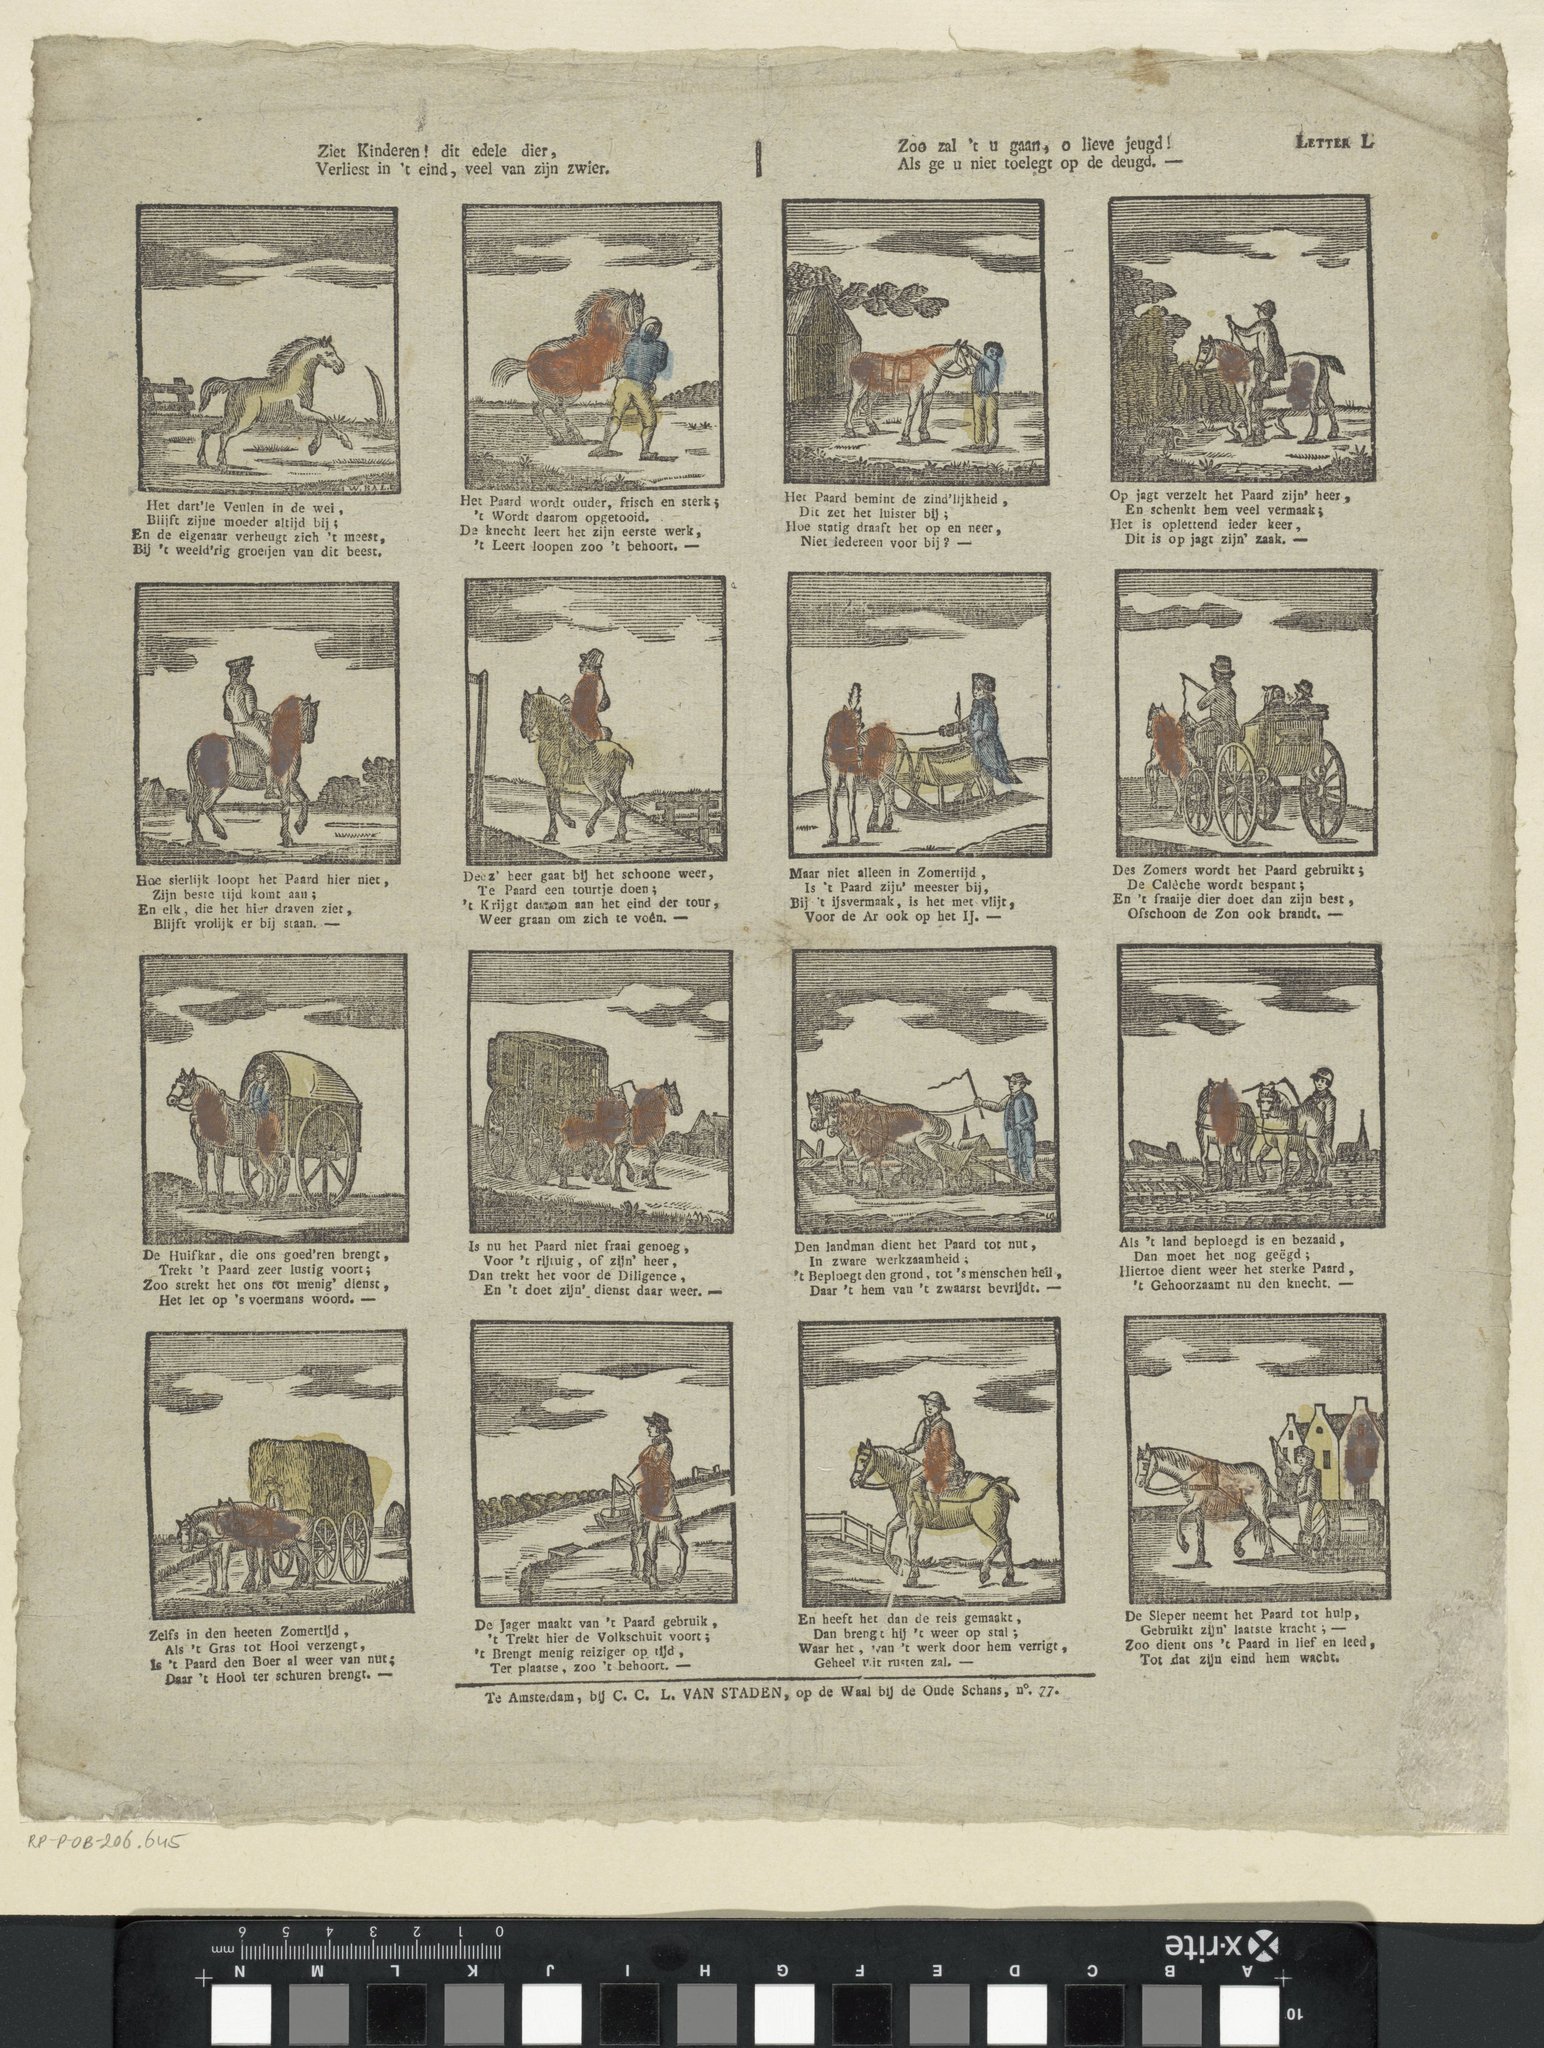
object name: print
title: Ziet kinderen! dit edele dier, / Verliest in 't eind, veel van zijn zwier. / Zoo zal 't u gaan, o lieve jeugd! / Als ge u niet toelegt op de deugd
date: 1822-1870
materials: paper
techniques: colour, letterpress printing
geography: netherlands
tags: four-wheeled, animal-drawn vehicle, e.g.: cab, carriage, coach, horse, two-wheeled vehicle drawn by one animal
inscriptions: collector's mark: Lugt 2760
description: Blad met 16 voorstellingen van de verschillende bezigheden van een paard. Onder elke voorstelling een vierregelig vers. Rechtsboven gemerkt: Letter L.